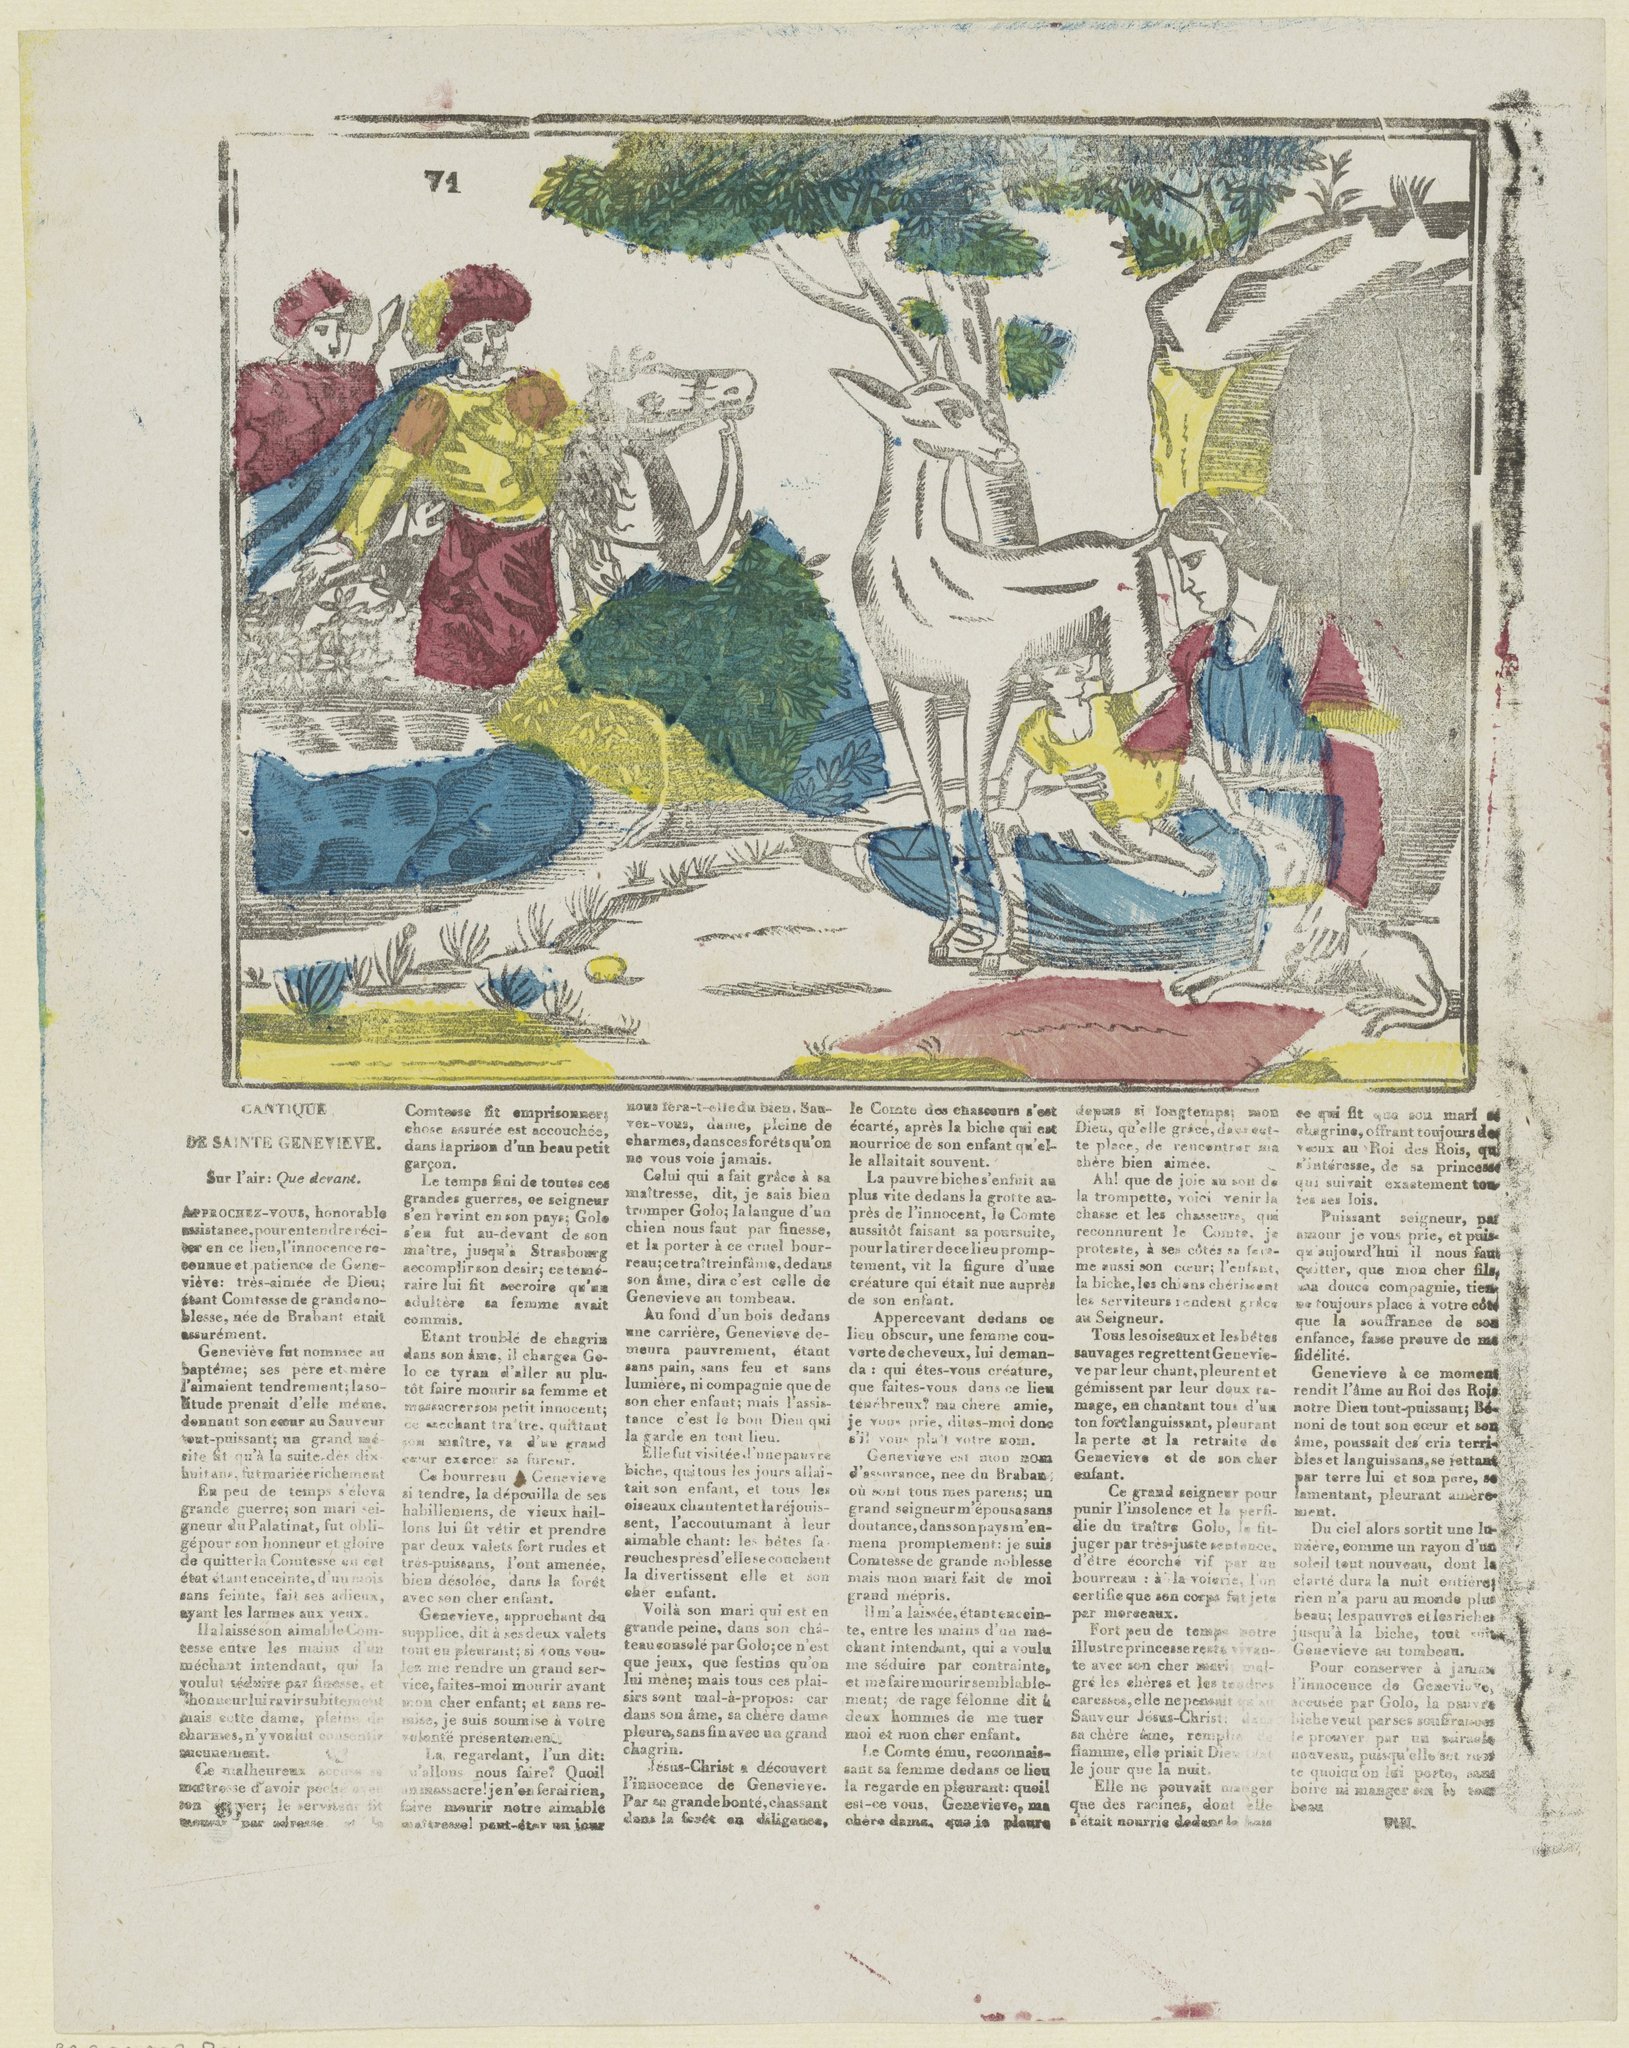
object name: print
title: Catinque de sainte Genevieve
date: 1827-1894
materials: paper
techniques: colour, letterpress printing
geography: schaarbeek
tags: genoveva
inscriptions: collector's mark: Lugt 2760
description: Blad met een grote voorstelling van Genoveva van Brabant. In de ondermarge een Franse tekst in zes kolommen. Genummerd linksboven: 71.